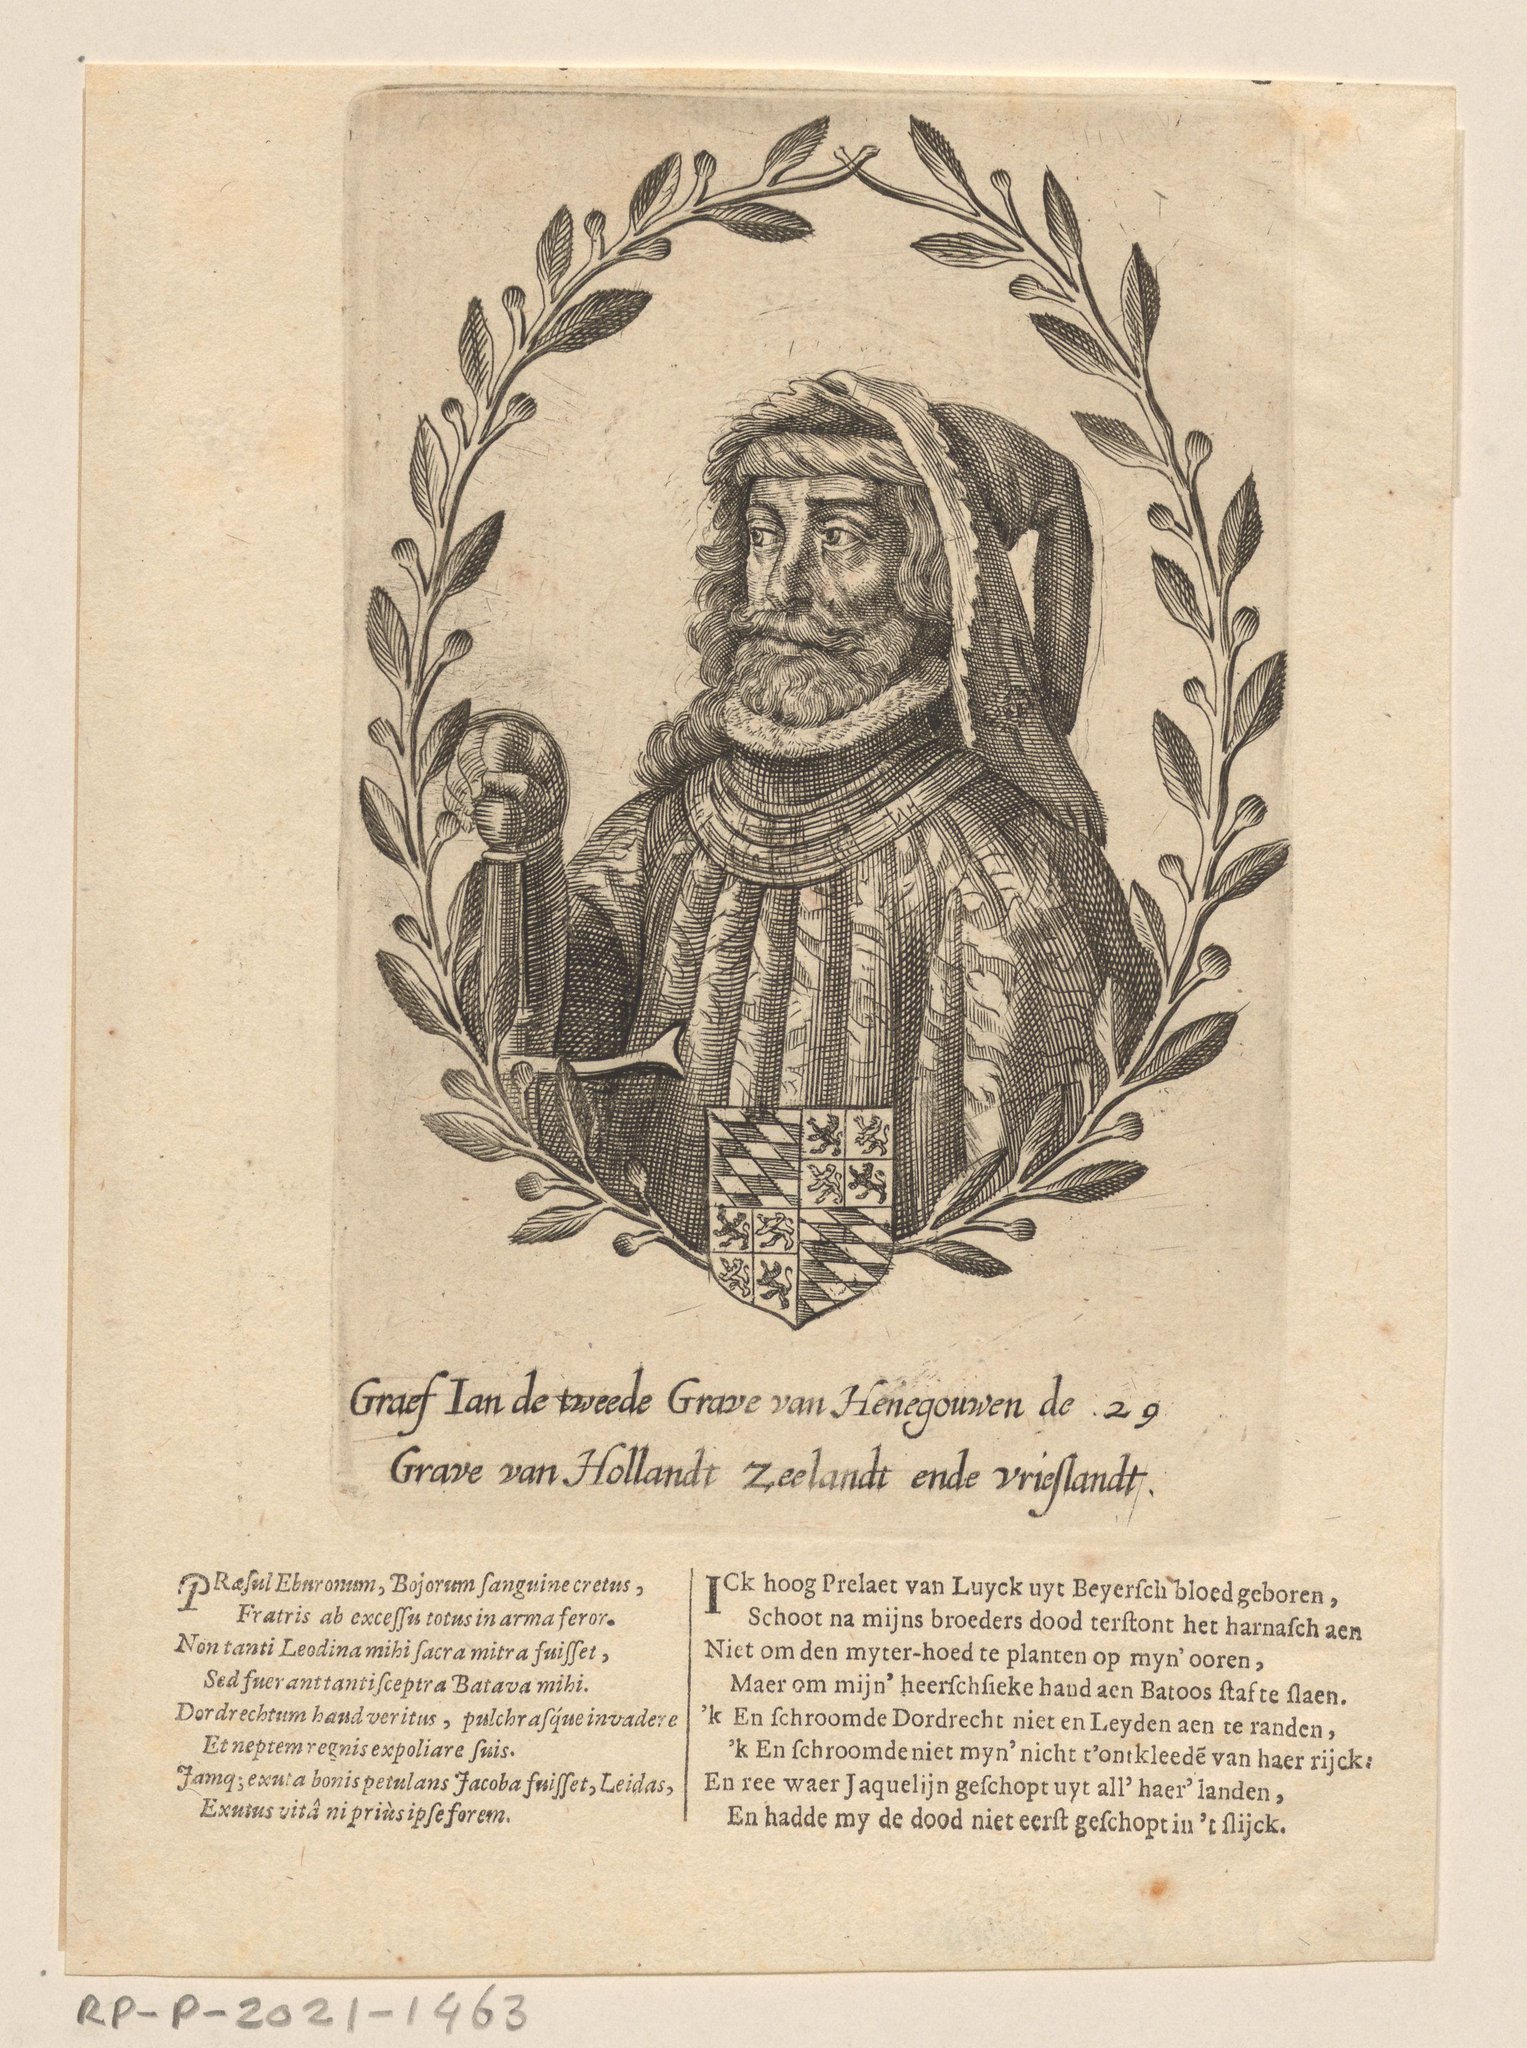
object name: print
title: Portret van Jan van Beieren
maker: Anonymous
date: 1667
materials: paper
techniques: engraving, letterpress printing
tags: jan van beieren, historical persons, head-gear: hat, ruler, sovereign, armorial bearing, heraldry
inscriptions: collector's mark: Lugt 964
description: Prent mogelijk uit: Scriverius, Petrus. Alle de graven van Hollant en WestVrieslant. Den Haag: Pieter Brugman, 1667, p. 409. Of uit: Scriverius, Petrus. Oude en nieuwe beschryvinge van Holland, Zeeland en Vriesland (...). Den Haag: Pieter Brughman, 1667, dl. 1, p. 409.